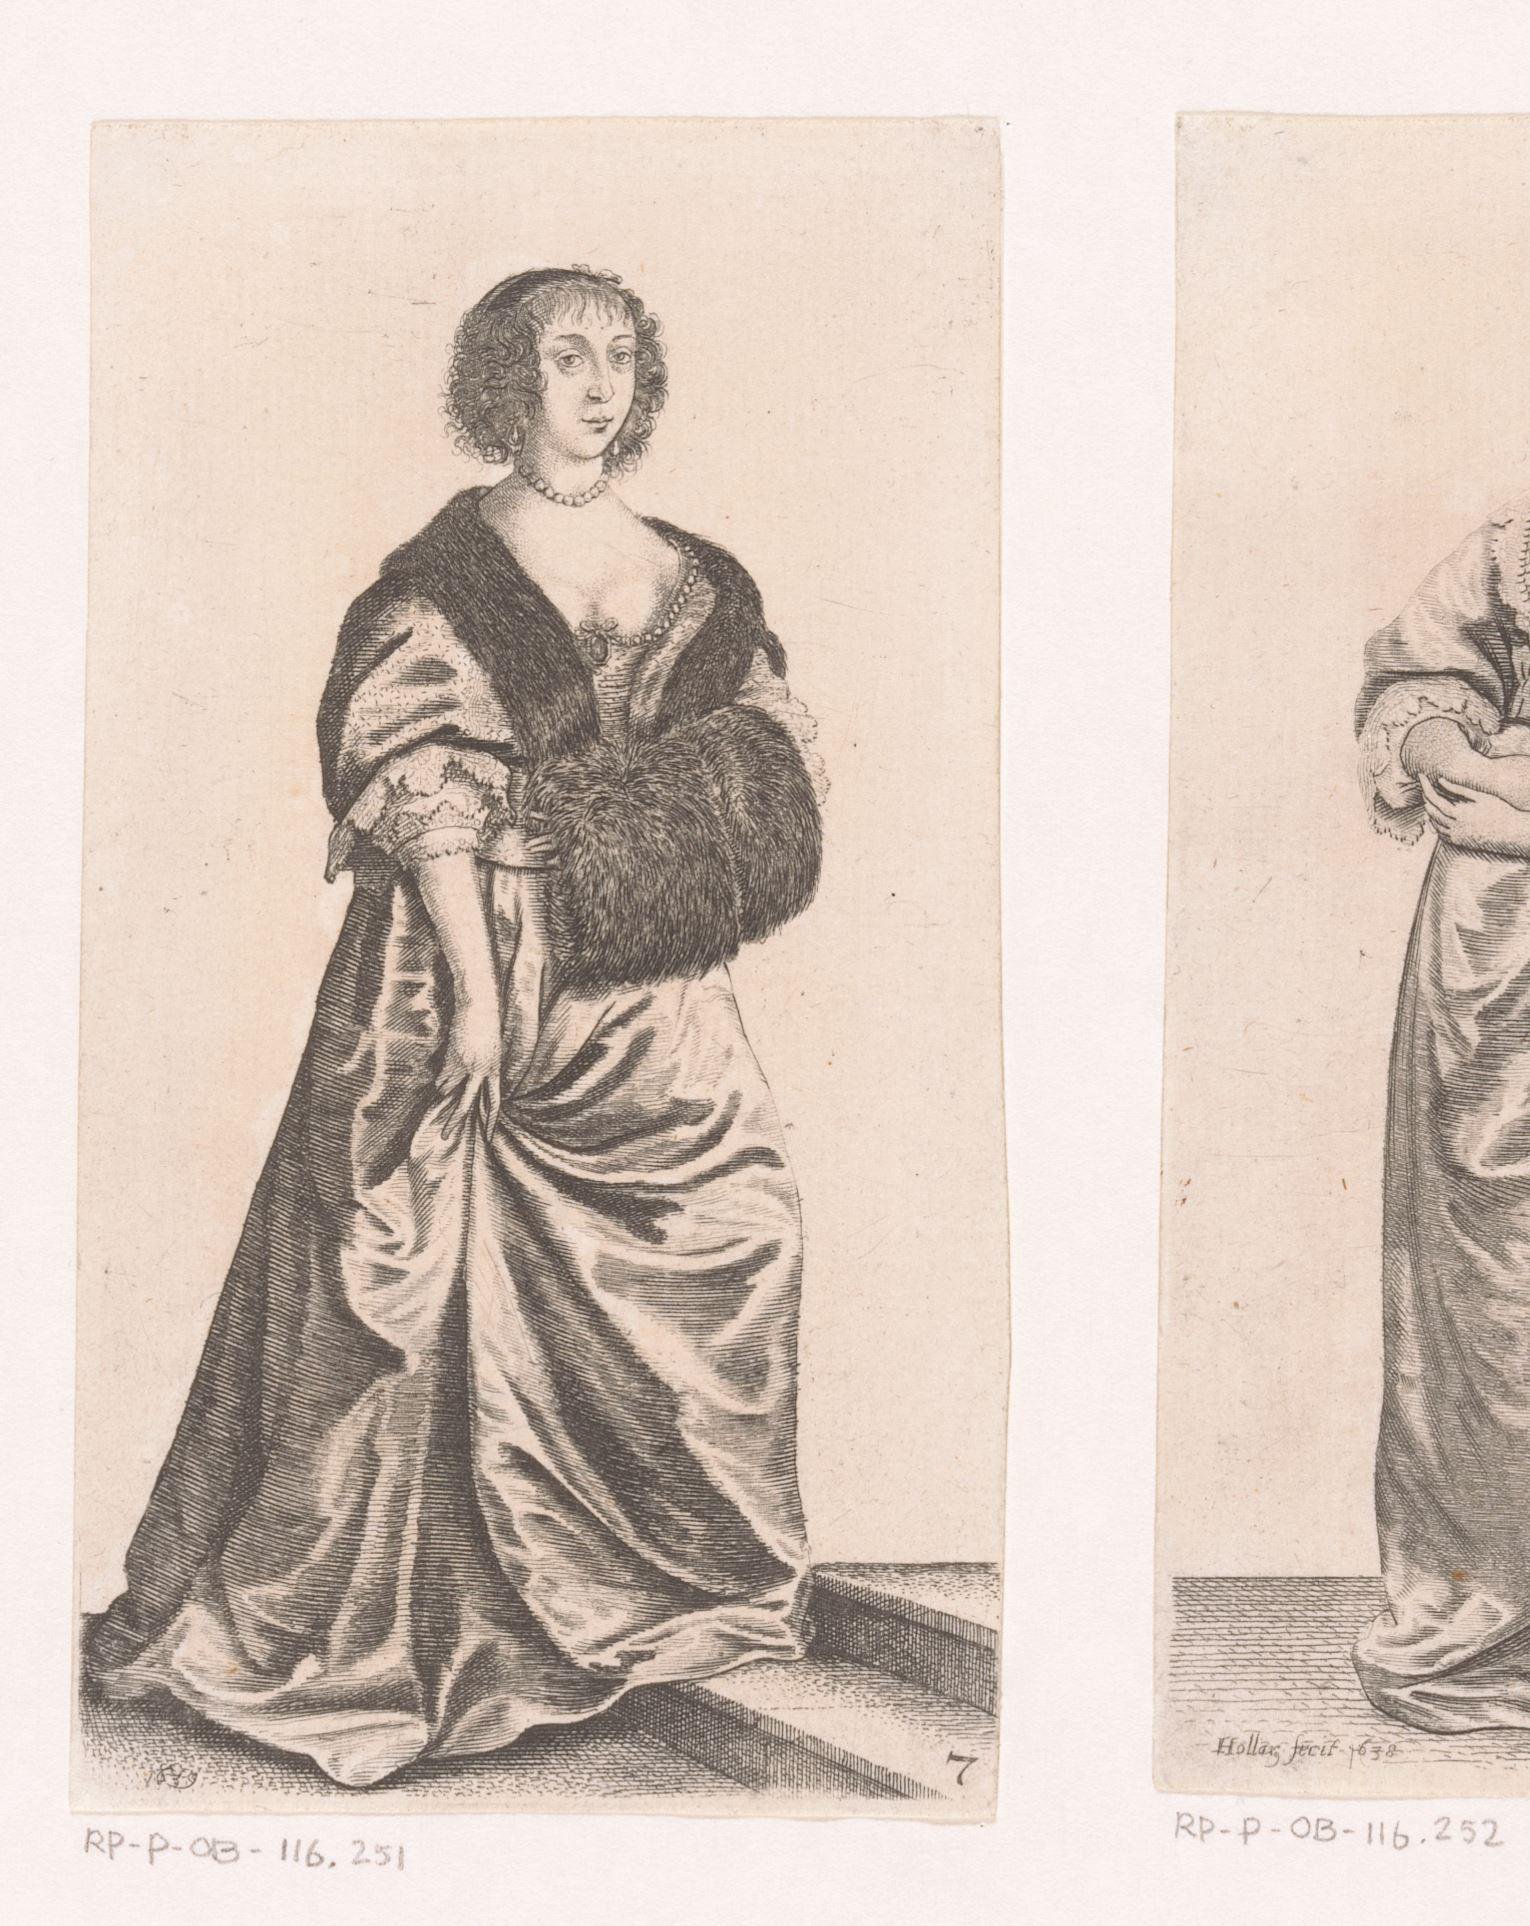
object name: costume print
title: Ornatus Muliebris Anglicanus / The Severall Habits of English Women, from the Nobilitie to the contry woman, they are in these times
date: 1639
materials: paper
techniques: etching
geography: london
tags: ear-rings (+ women's clothes), muff, europeans: englishmen (+ women), styles of hairdress - aa - ~ women, fashion plates, clothes, costume (+ women's clothes), pearl; pearl necklace (+ women's clothes)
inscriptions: collector's mark: Lugt 2760, collector's mark: Lugt 2228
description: Engelse vrouw, staand op een traptrede, met de rechterhand de japon iets ophoudend. Druppelvormige oorhangers en rond de hals een parelsnoer. Gekleed in een japon met rond de schouders een parelsnoer, waarover een stola van bont. In de linkerhand een grote mof van bont.